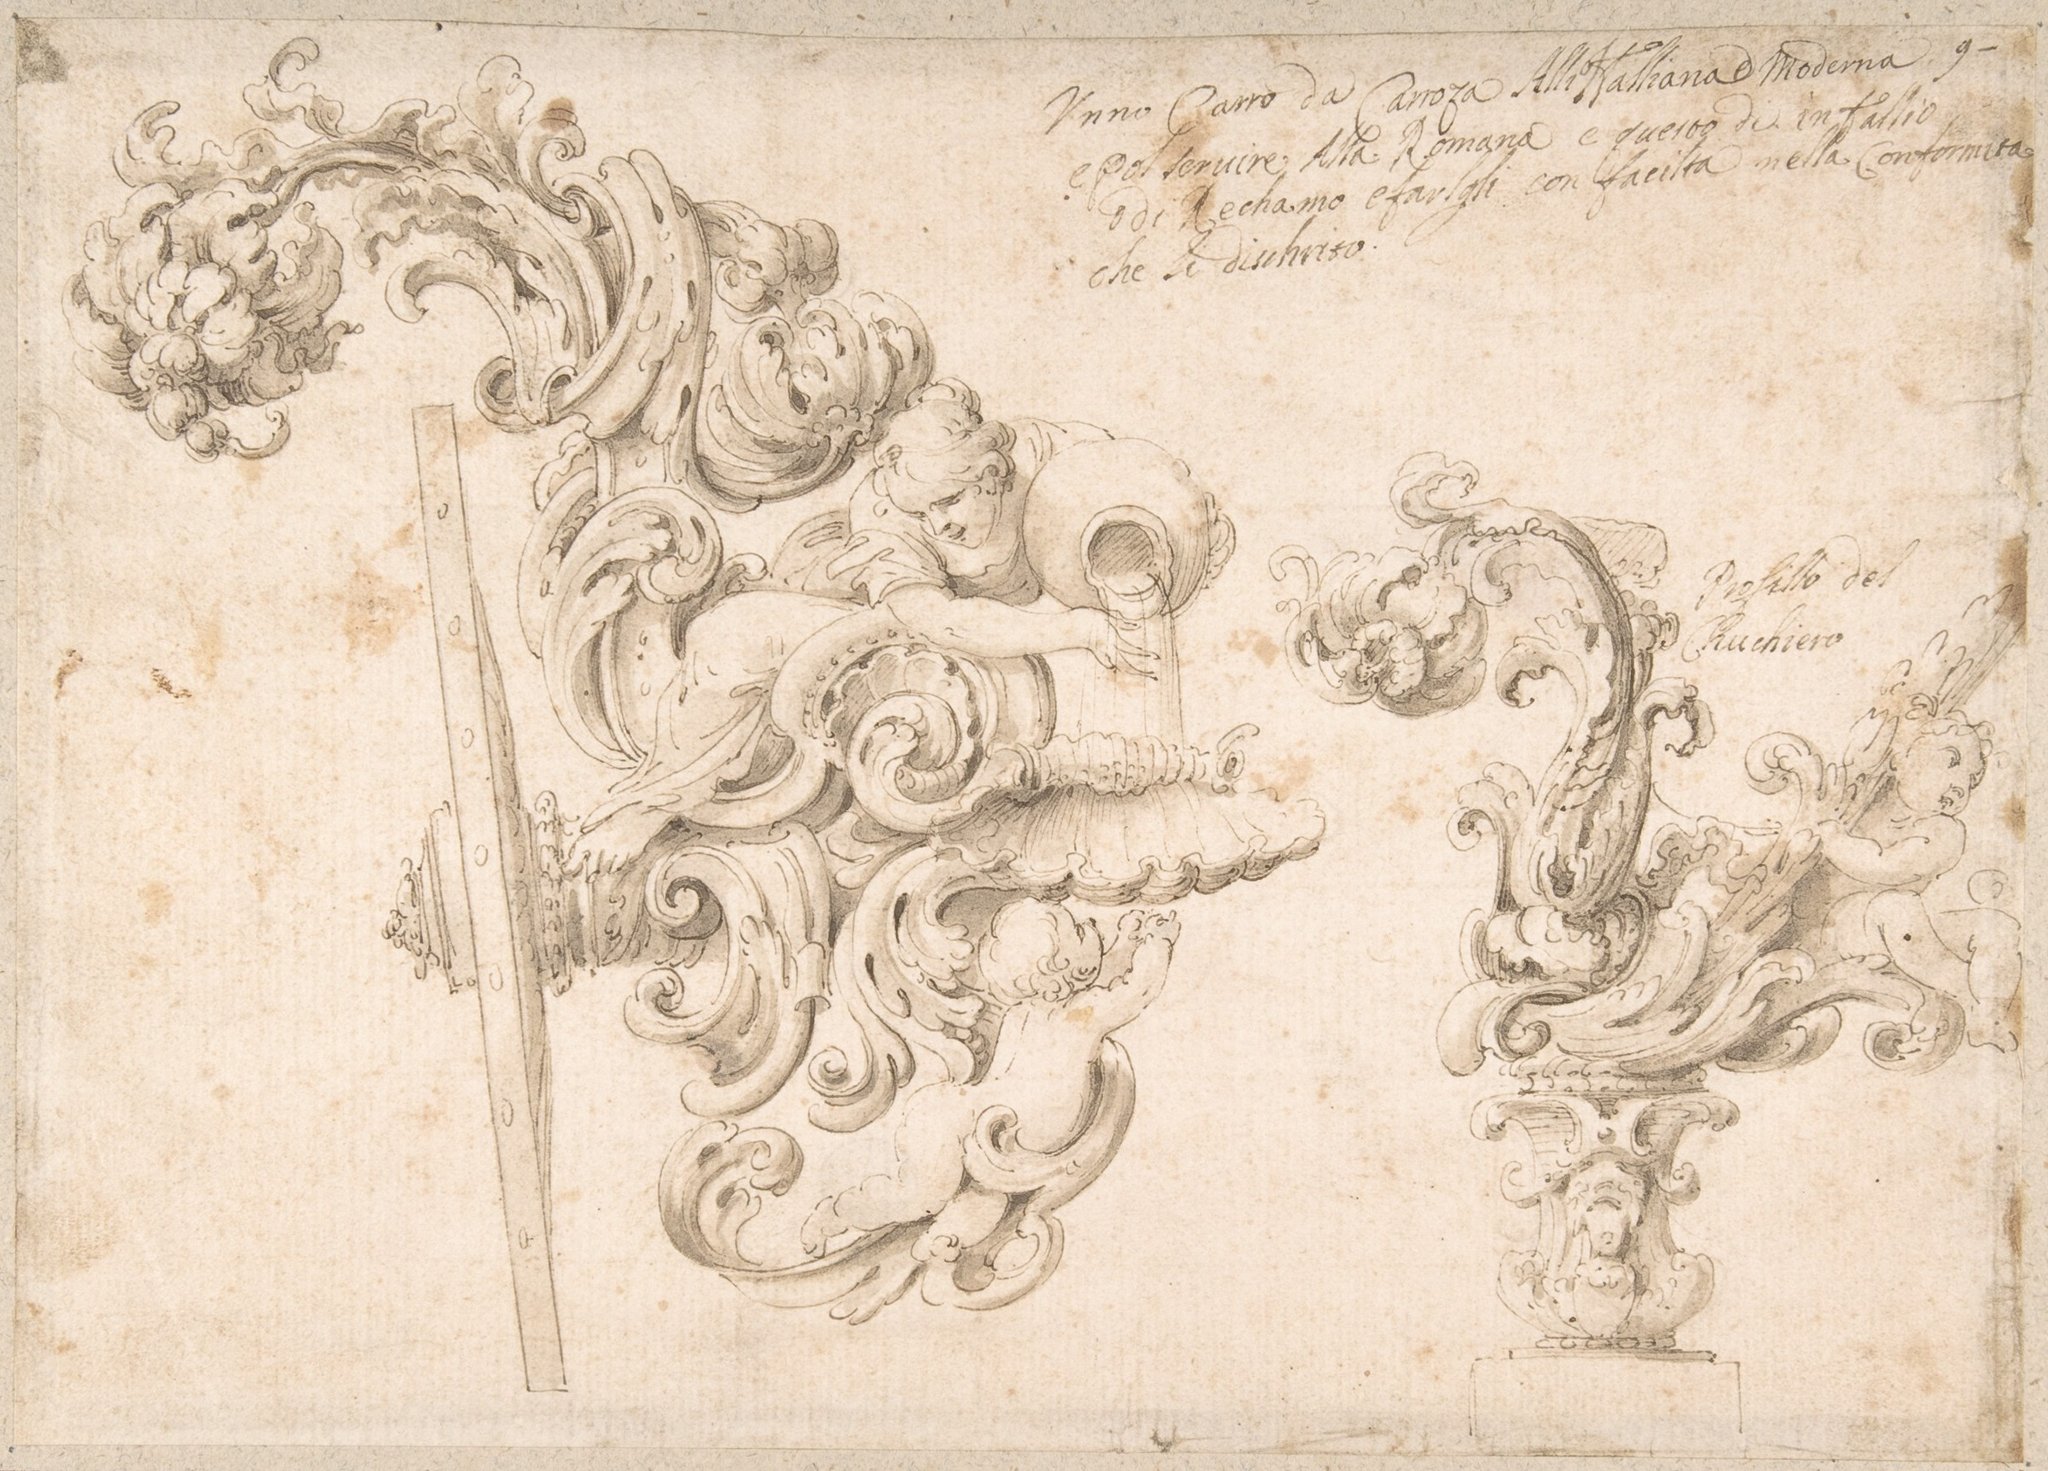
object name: drawing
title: Design for the Rear of a Coach with a Girl Pouring Water into a Shell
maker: anonymous, italian, 17th century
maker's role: artist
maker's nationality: italian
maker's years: 1600-1700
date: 1601-1700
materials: ink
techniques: brush, pen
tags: girls